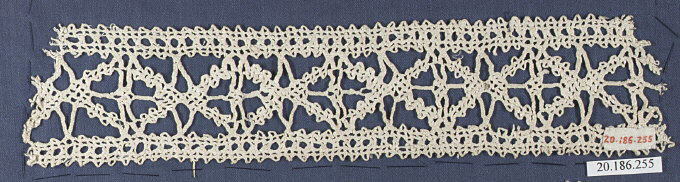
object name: insertion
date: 1501-1600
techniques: lace